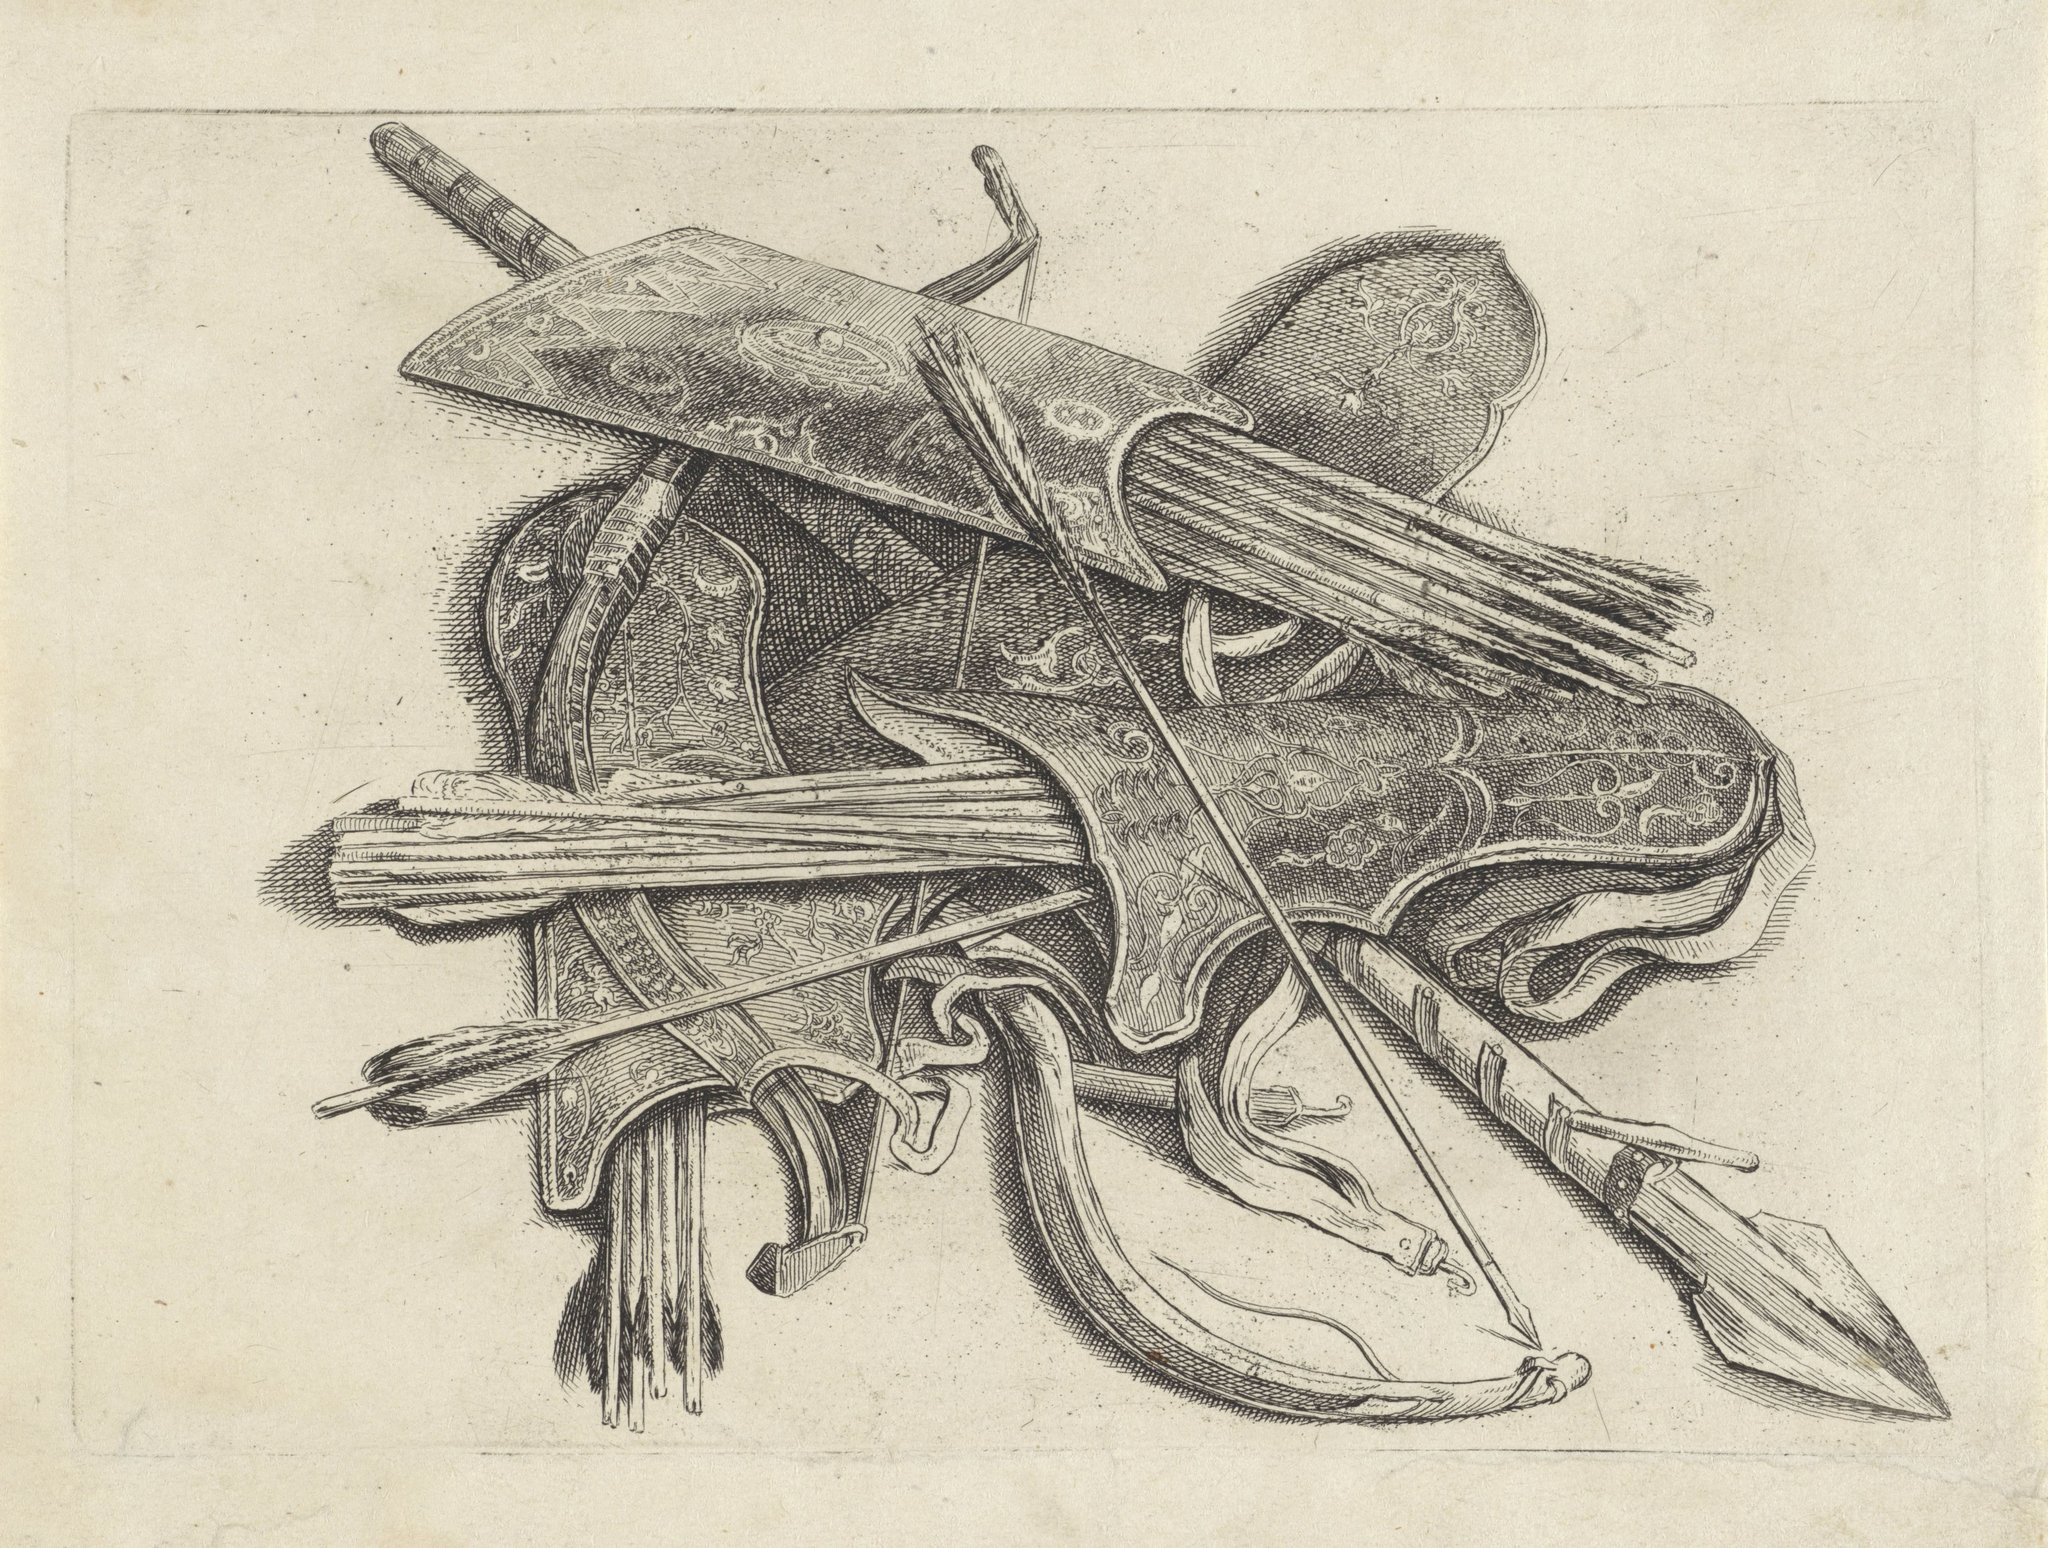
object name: print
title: Jacht, jachthonden en wild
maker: wenceslaus hollar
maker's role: draughtsman, print maker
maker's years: 1607-1677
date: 1646-1647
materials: paper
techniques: etching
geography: antwerp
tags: archer's weapons: bow and arrow, hunting accoutrement, hunting horn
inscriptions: collector's mark: Lugt 2228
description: Prent uit twintigdelige serie (incl. titelprent) met voorstellingen over de jacht: "Jacht, jachthonden en wild".